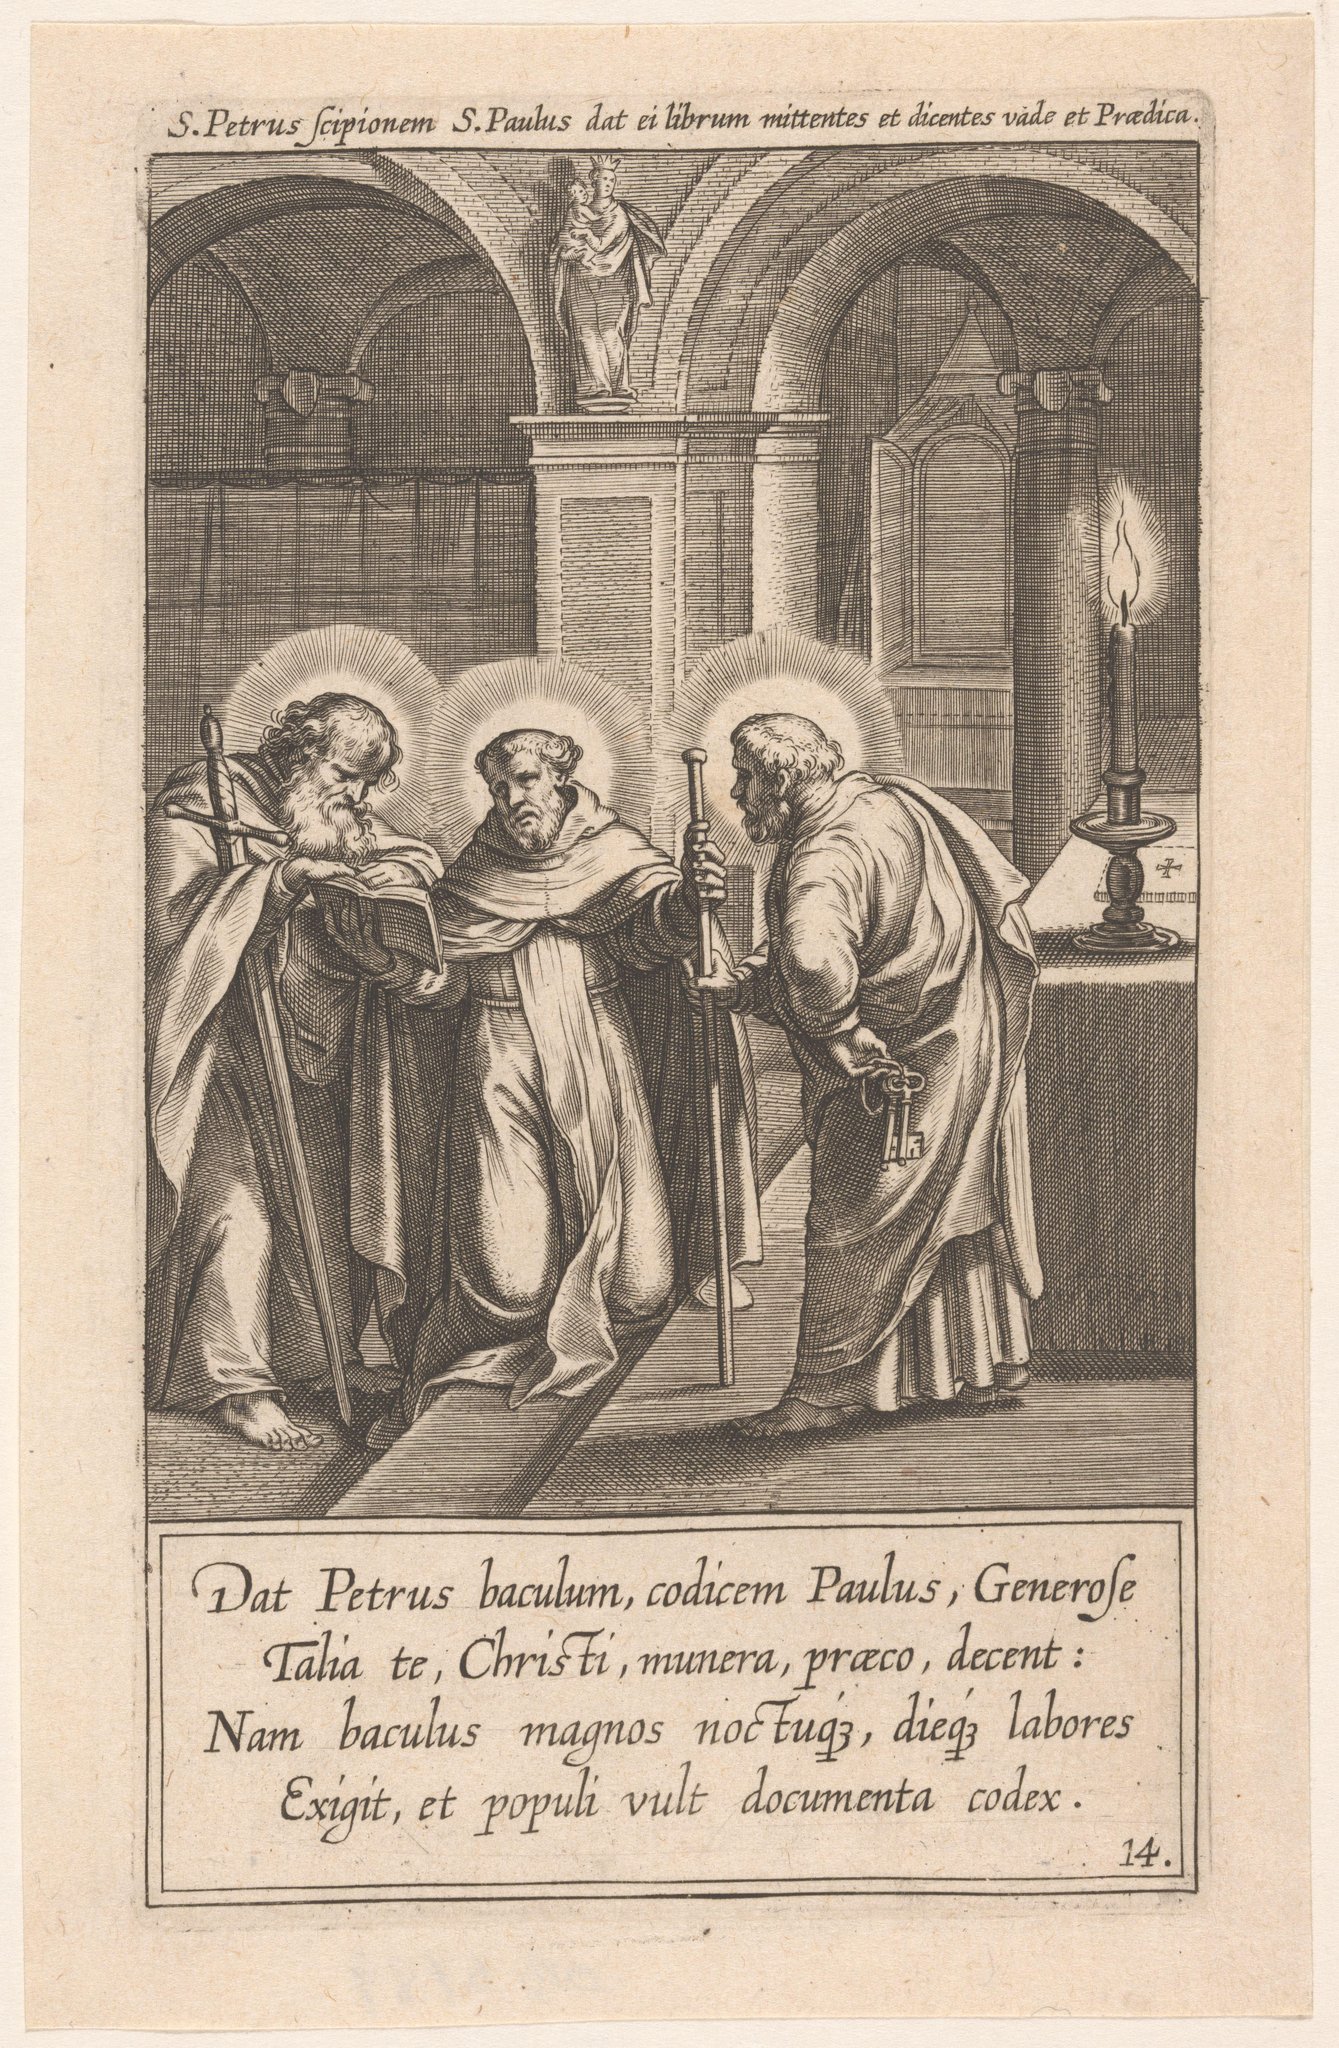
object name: print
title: Visioen van de heilige Dominicus over de apostelen Petrus en Paulus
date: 1611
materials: paper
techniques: engraving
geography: antwerp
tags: st. dominic receives the commission to preach: st. peter and st. paul appear to him in a vision and give him a staff and a book (the gospels)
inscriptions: collector's mark: Lugt 2228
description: In de Sint-Pieterskerk te Rome krijgt de heilige Dominicus in een visioen het bezoek van de apostelen Petrus en Paulus. Ze geven hem respectievelijk een staf en een boek en bevelen hem aan het woord van God te verspreiden. De prent heeft een Latijns opschrift en onderschrift en maakt deel uit van een prentserie voor een boek over het leven van de heilige Dominicus.